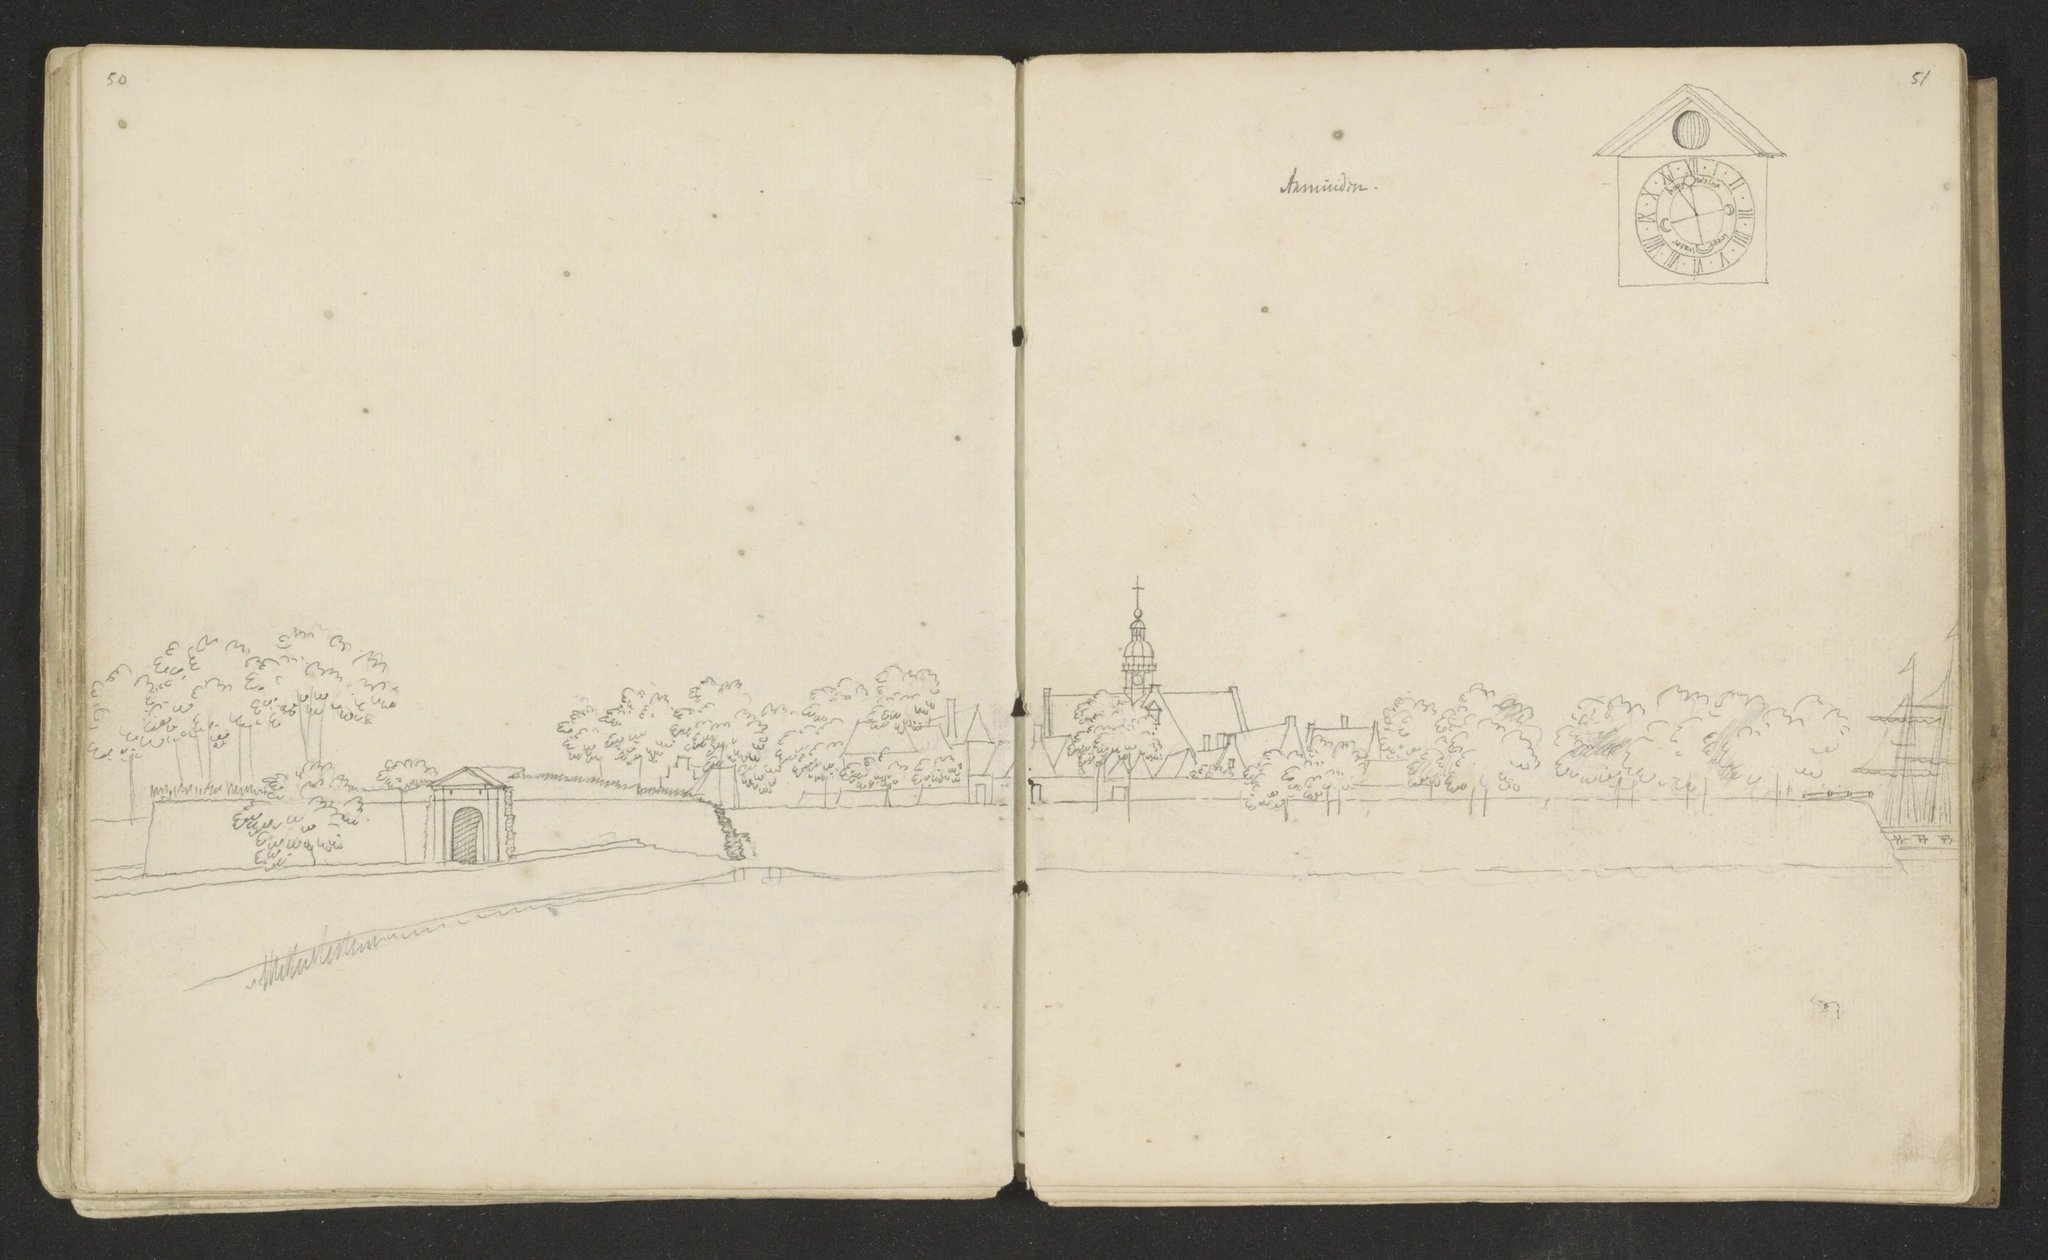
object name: sketchbook leaf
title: Stadsgezicht op Arnemuiden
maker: cornelis pronk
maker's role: draughtsman, painter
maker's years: 1691-1759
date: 1728-1732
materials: ink, paper, pencil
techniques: pen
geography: arnemuiden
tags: city-walls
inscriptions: annotation: ‘Arnemuiden’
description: Op de voorgrond links resten van de stadsmuur met een stadspoort en rechts de begroeide stadswal. Boven de muur en wal zijn de daken van de kerk en huizen zichtbaar. Tevens een studie van een uurwerk. Bladzijde 50 en 51 uit een schetsboek met 96 bladzijden.